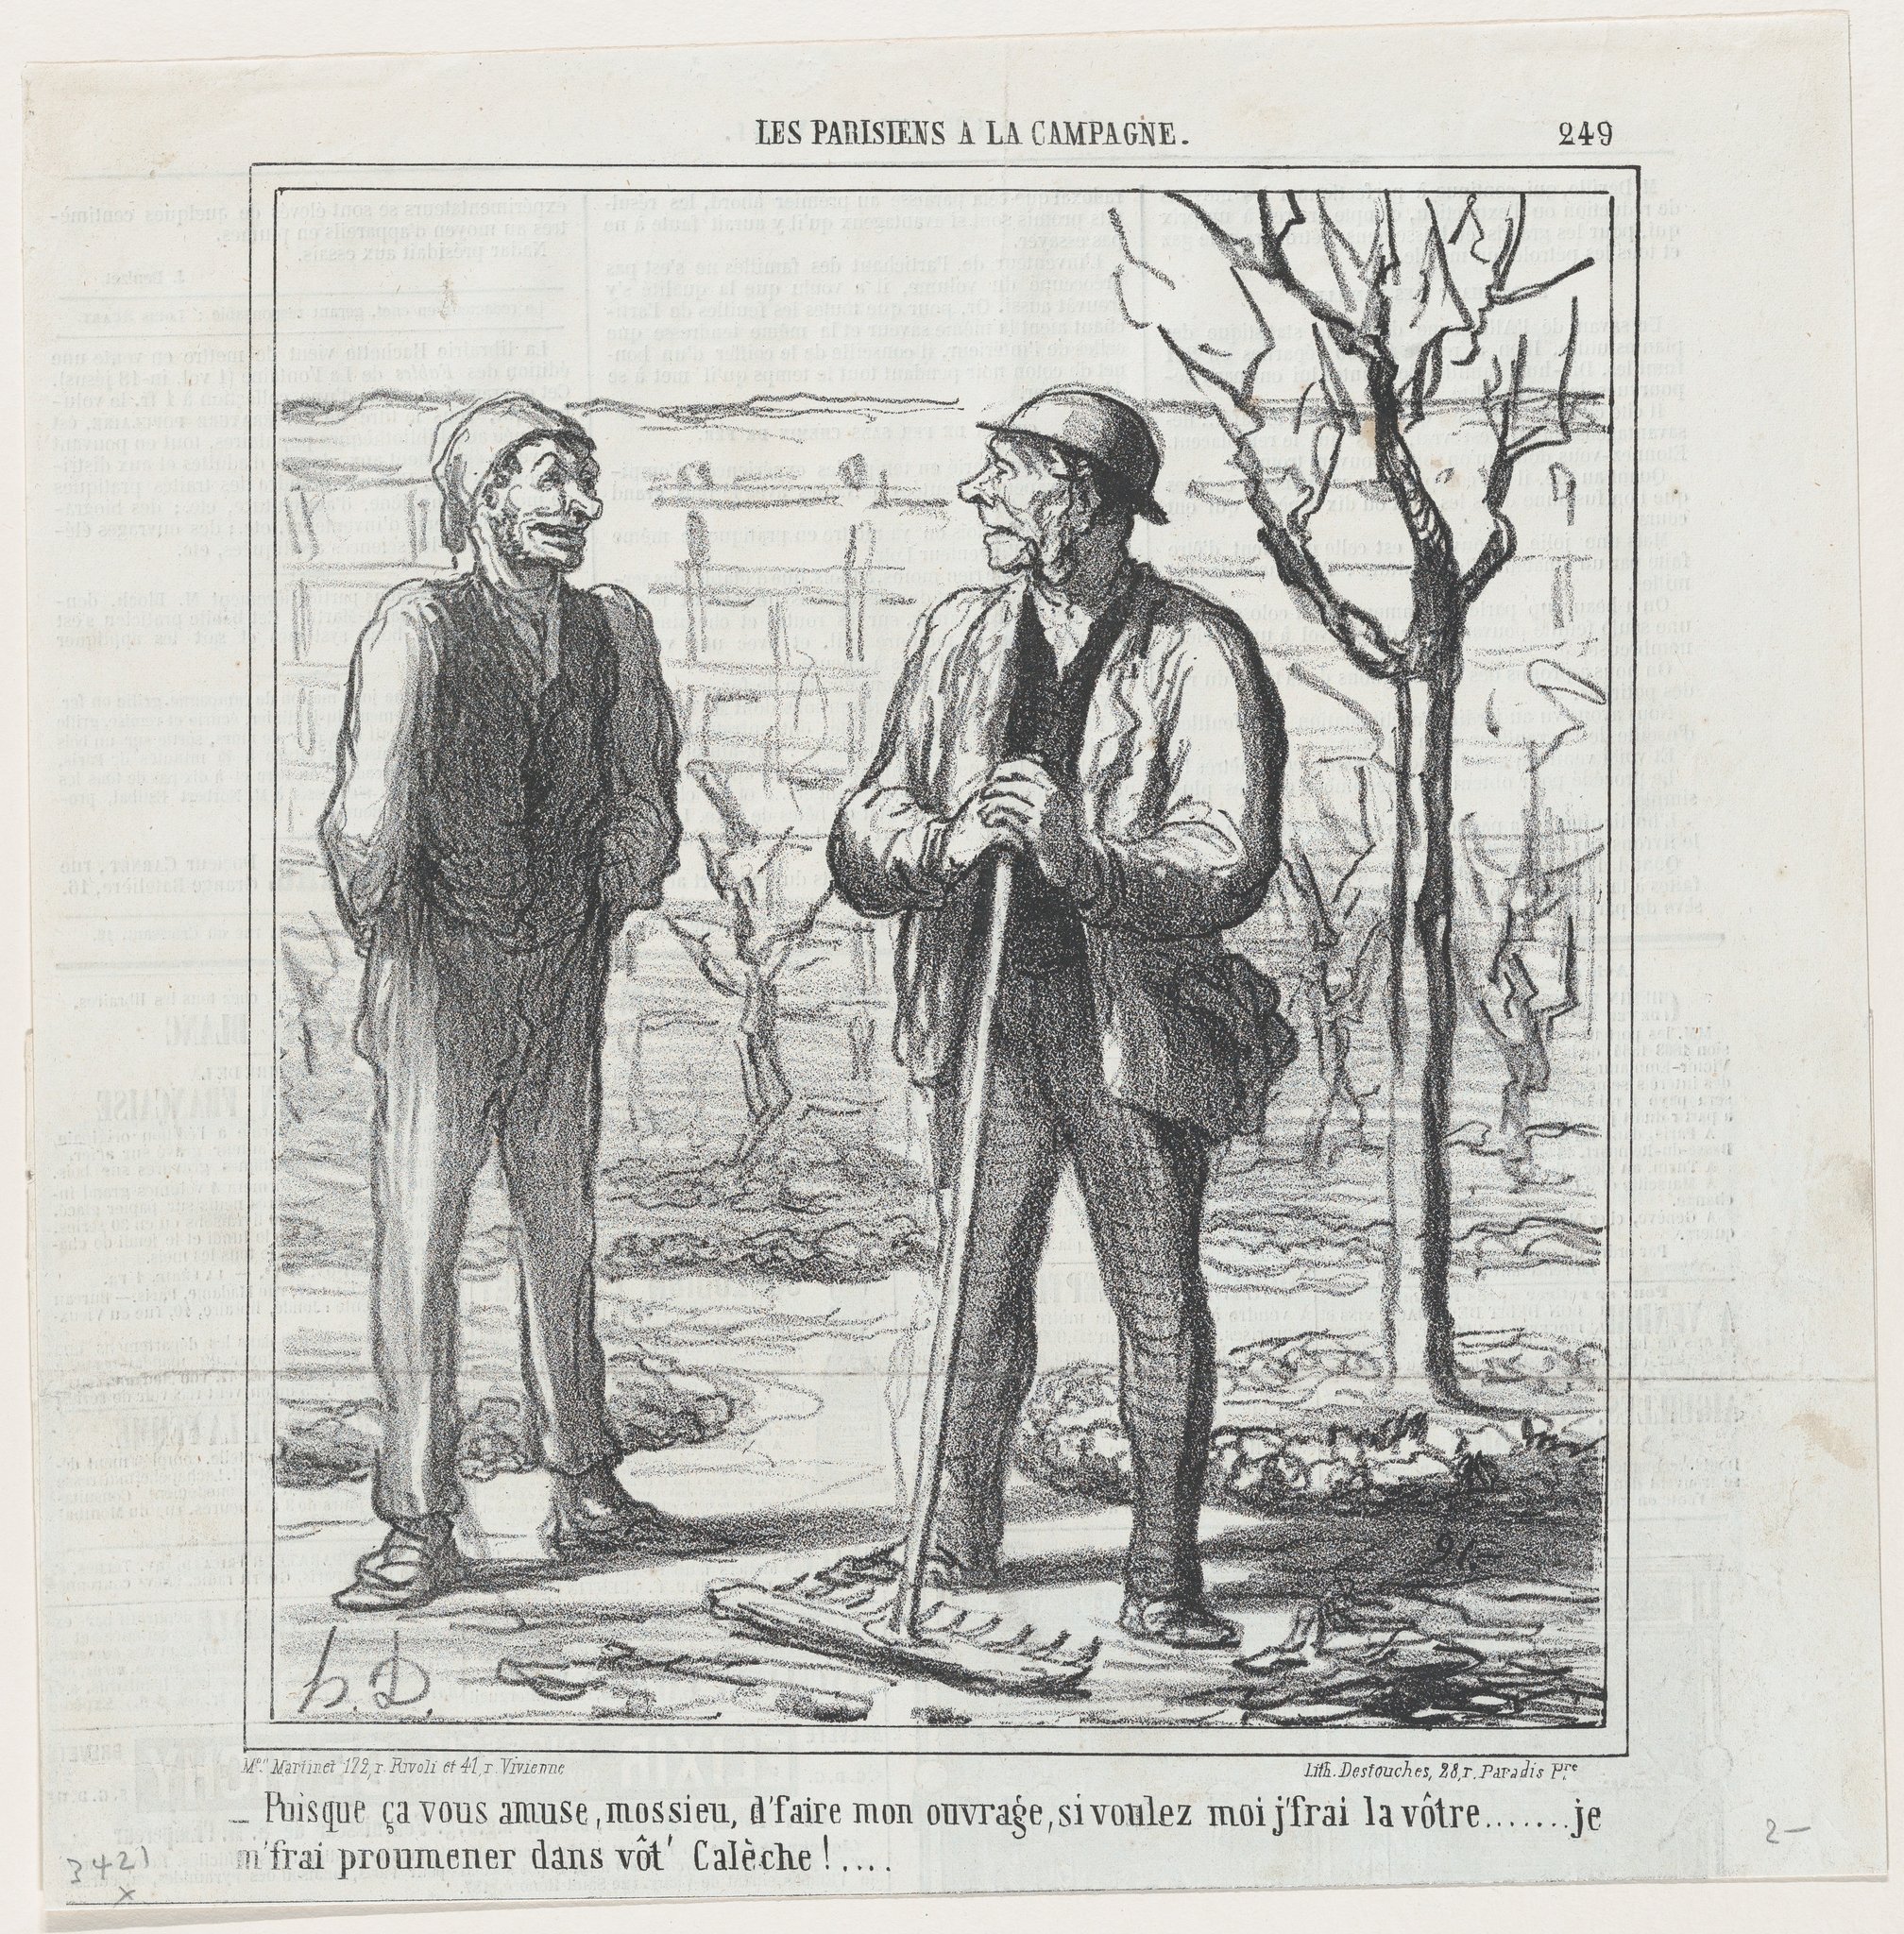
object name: print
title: You seem to enjoy doing my work. In exchange I could offer doing your job: I will go for a ride in your coach!, from "Parisians in the countryside"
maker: honoré daumier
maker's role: artist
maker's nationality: french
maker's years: 1808-1879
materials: paper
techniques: lithograph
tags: men,working